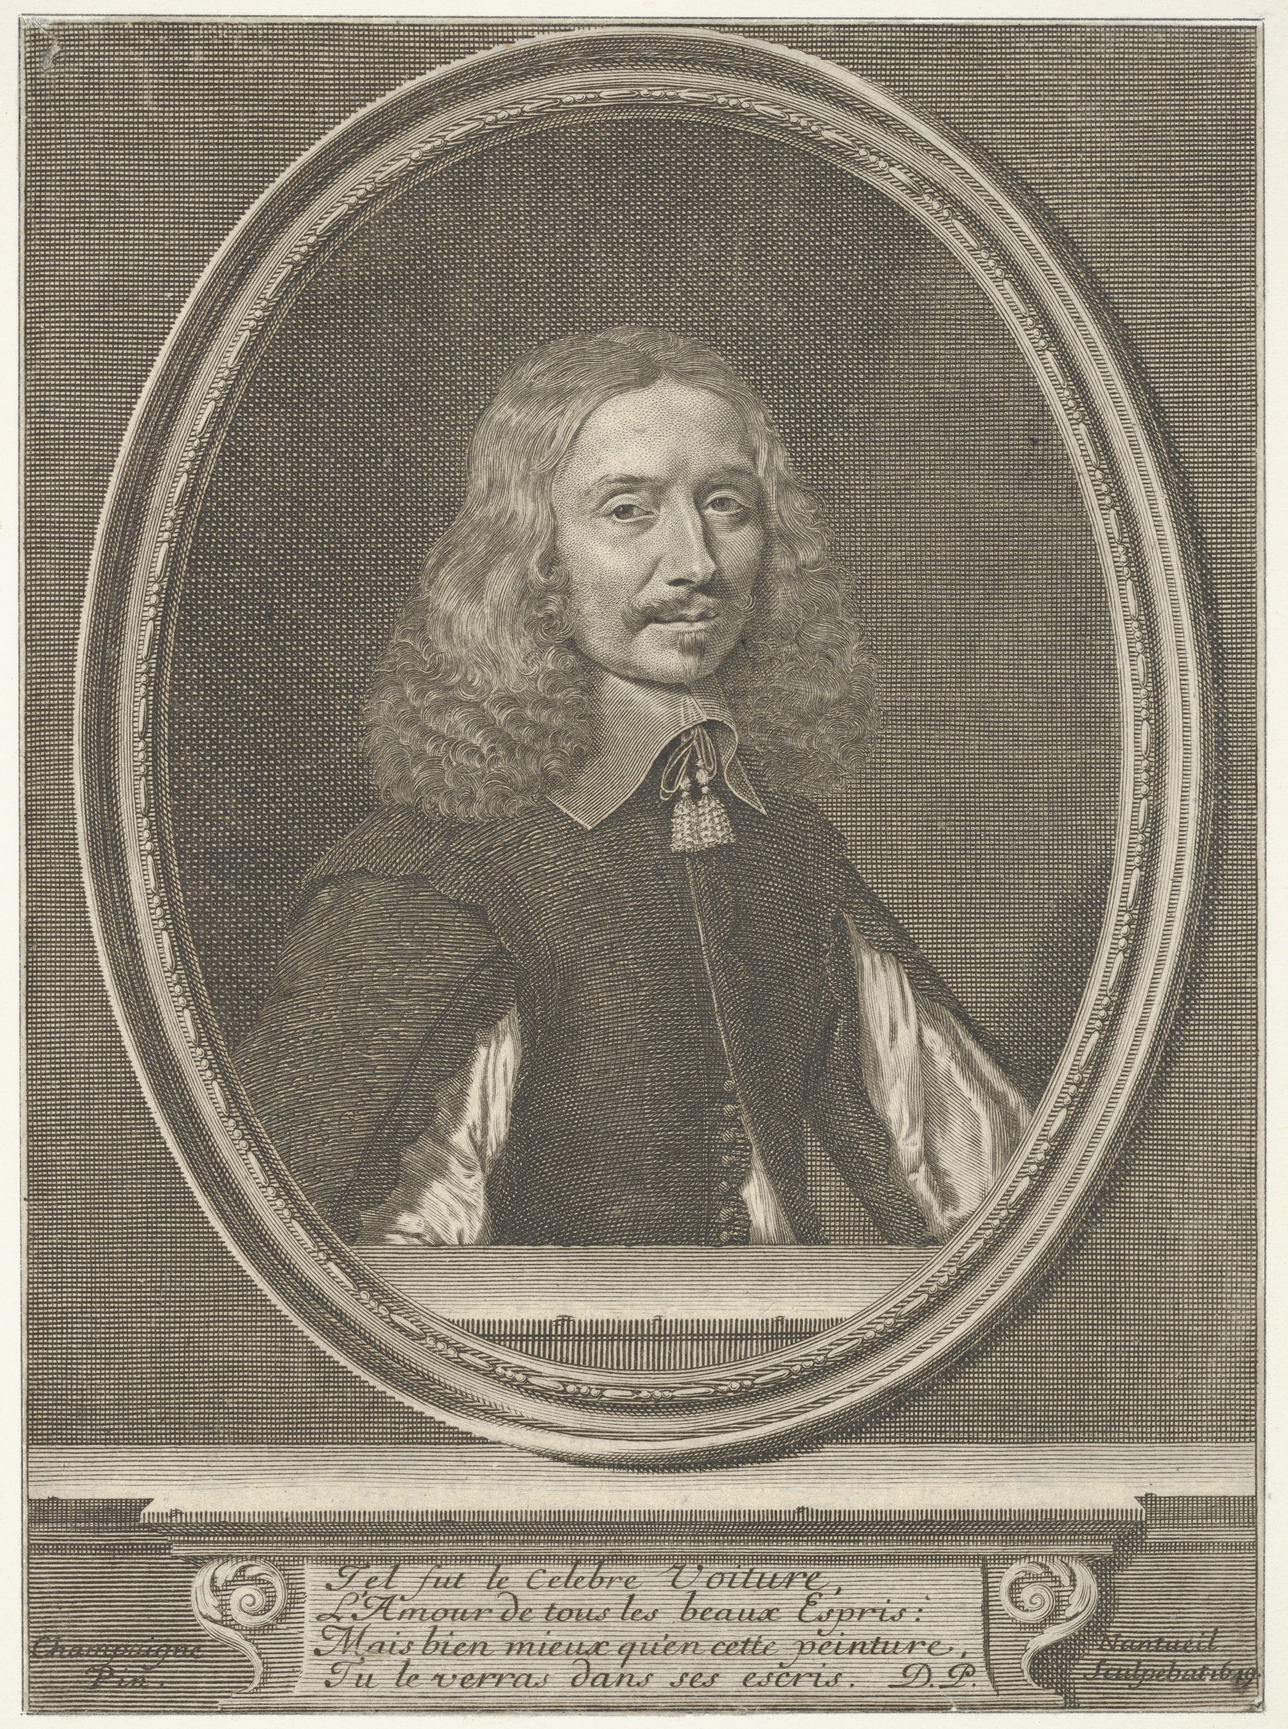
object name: print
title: Vincent Voiture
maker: robert nanteuil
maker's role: artist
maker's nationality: french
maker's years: 1623-1678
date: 1649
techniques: engraving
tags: men,portraits